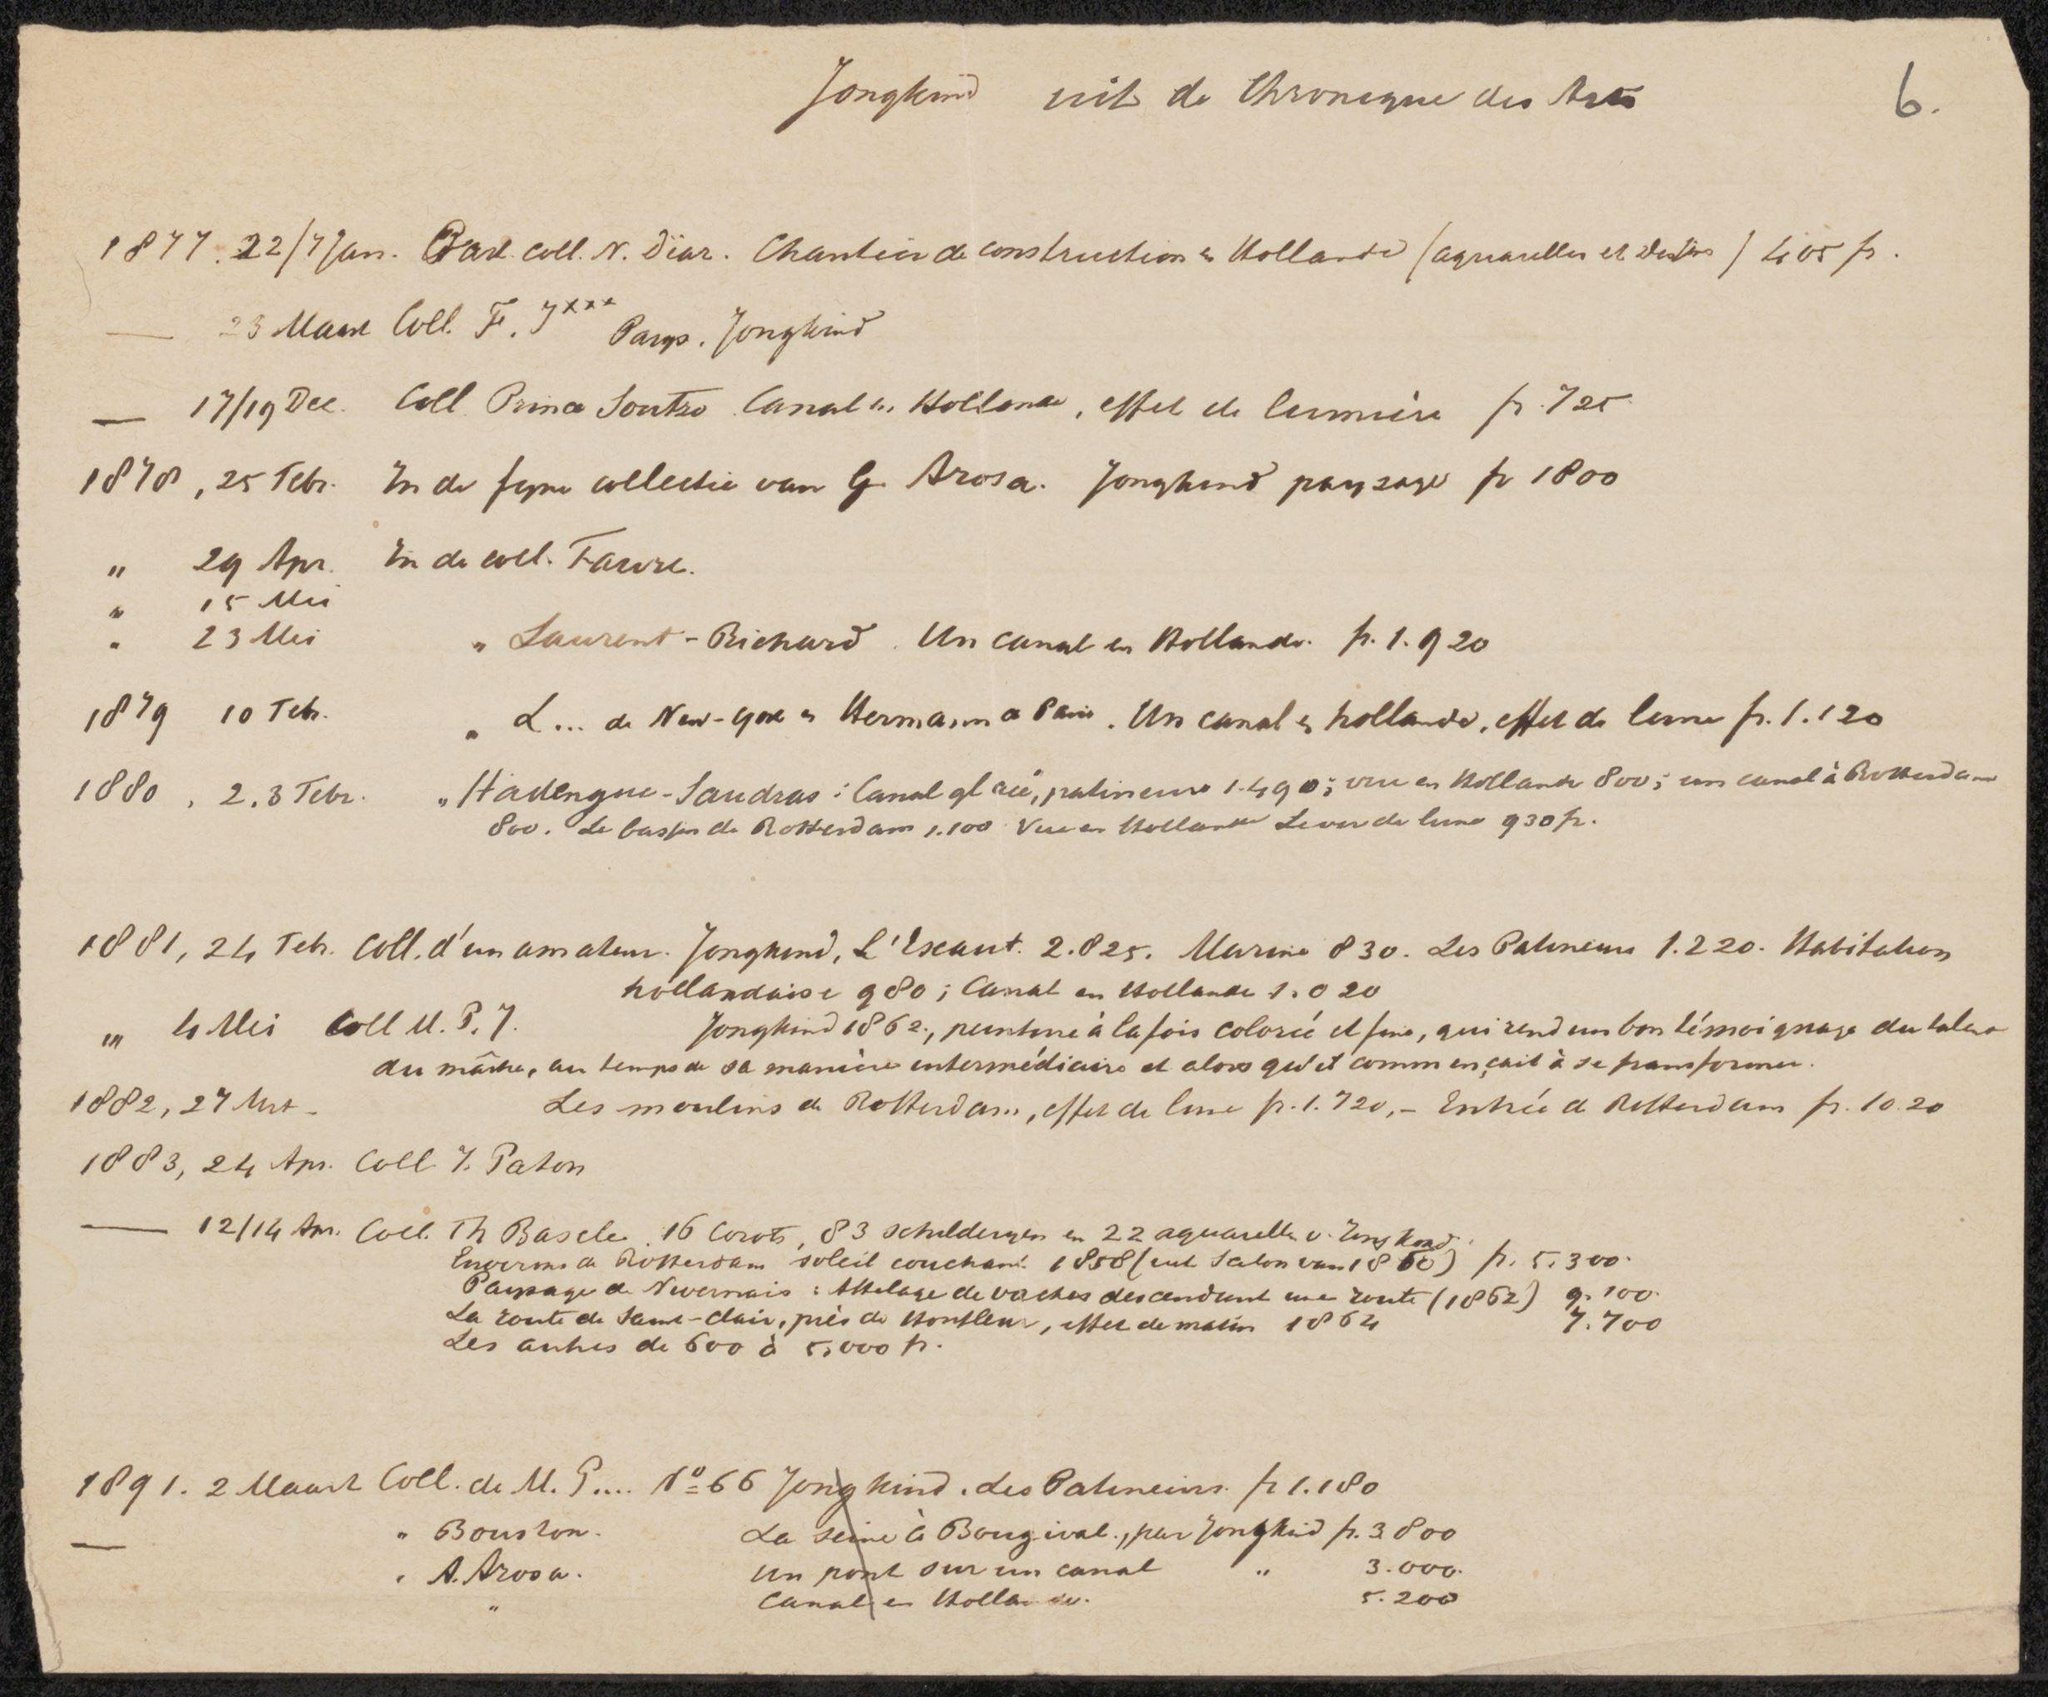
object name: aantekening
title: Aantekening betreffende Johan Barthold Jongkind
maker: Anonymous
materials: ink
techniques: pen, writing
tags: painter, print maker, draughtsman, johan barthold jongkind, painting (including book-illumination, miniature-painting), money